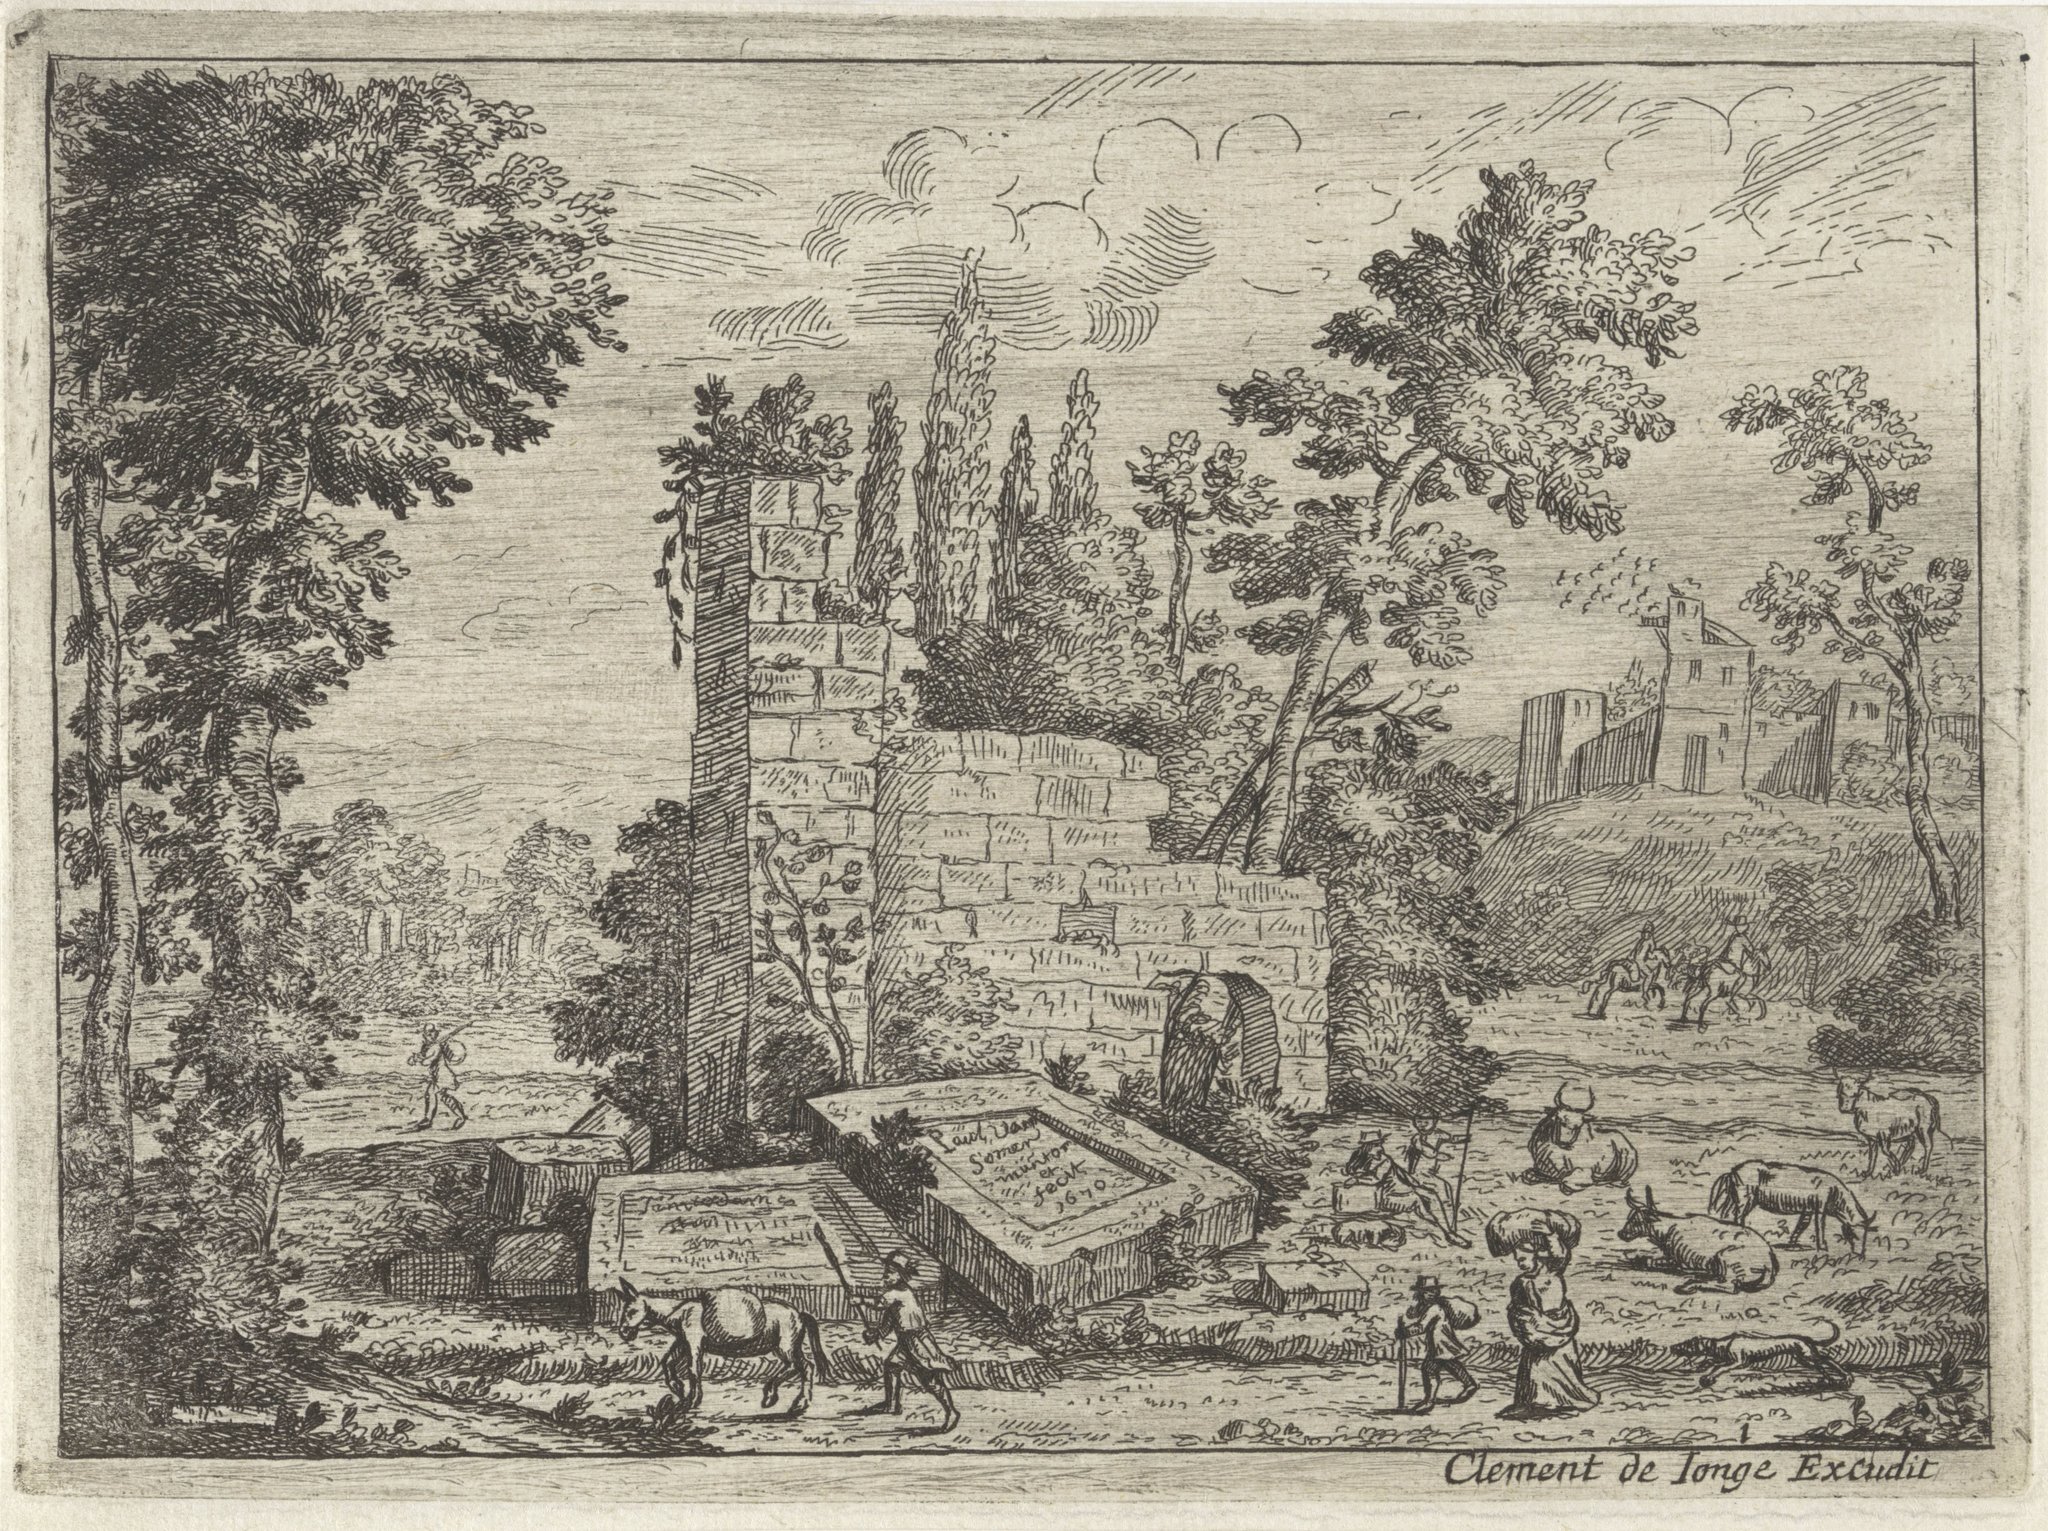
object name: print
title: Pastorale landschappen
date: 1670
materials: paper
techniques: engraving, etching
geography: amsterdam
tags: pastorals, arcadian scenes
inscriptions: number: ‘No. 92’, collector's mark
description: Op de grond voor een ruïne liggen twee grote stenen afdekplaten. Op een van beide staat de naam van de prentmaker en het vervaardigingsjaar. Naast de ruïne rusten herders met hun kudde. Op de achtergrond een heuvel met de ruïne van een kasteel. Op de voorgrond loopt een weg, waarover mensen lopen met een hond en een ezel.